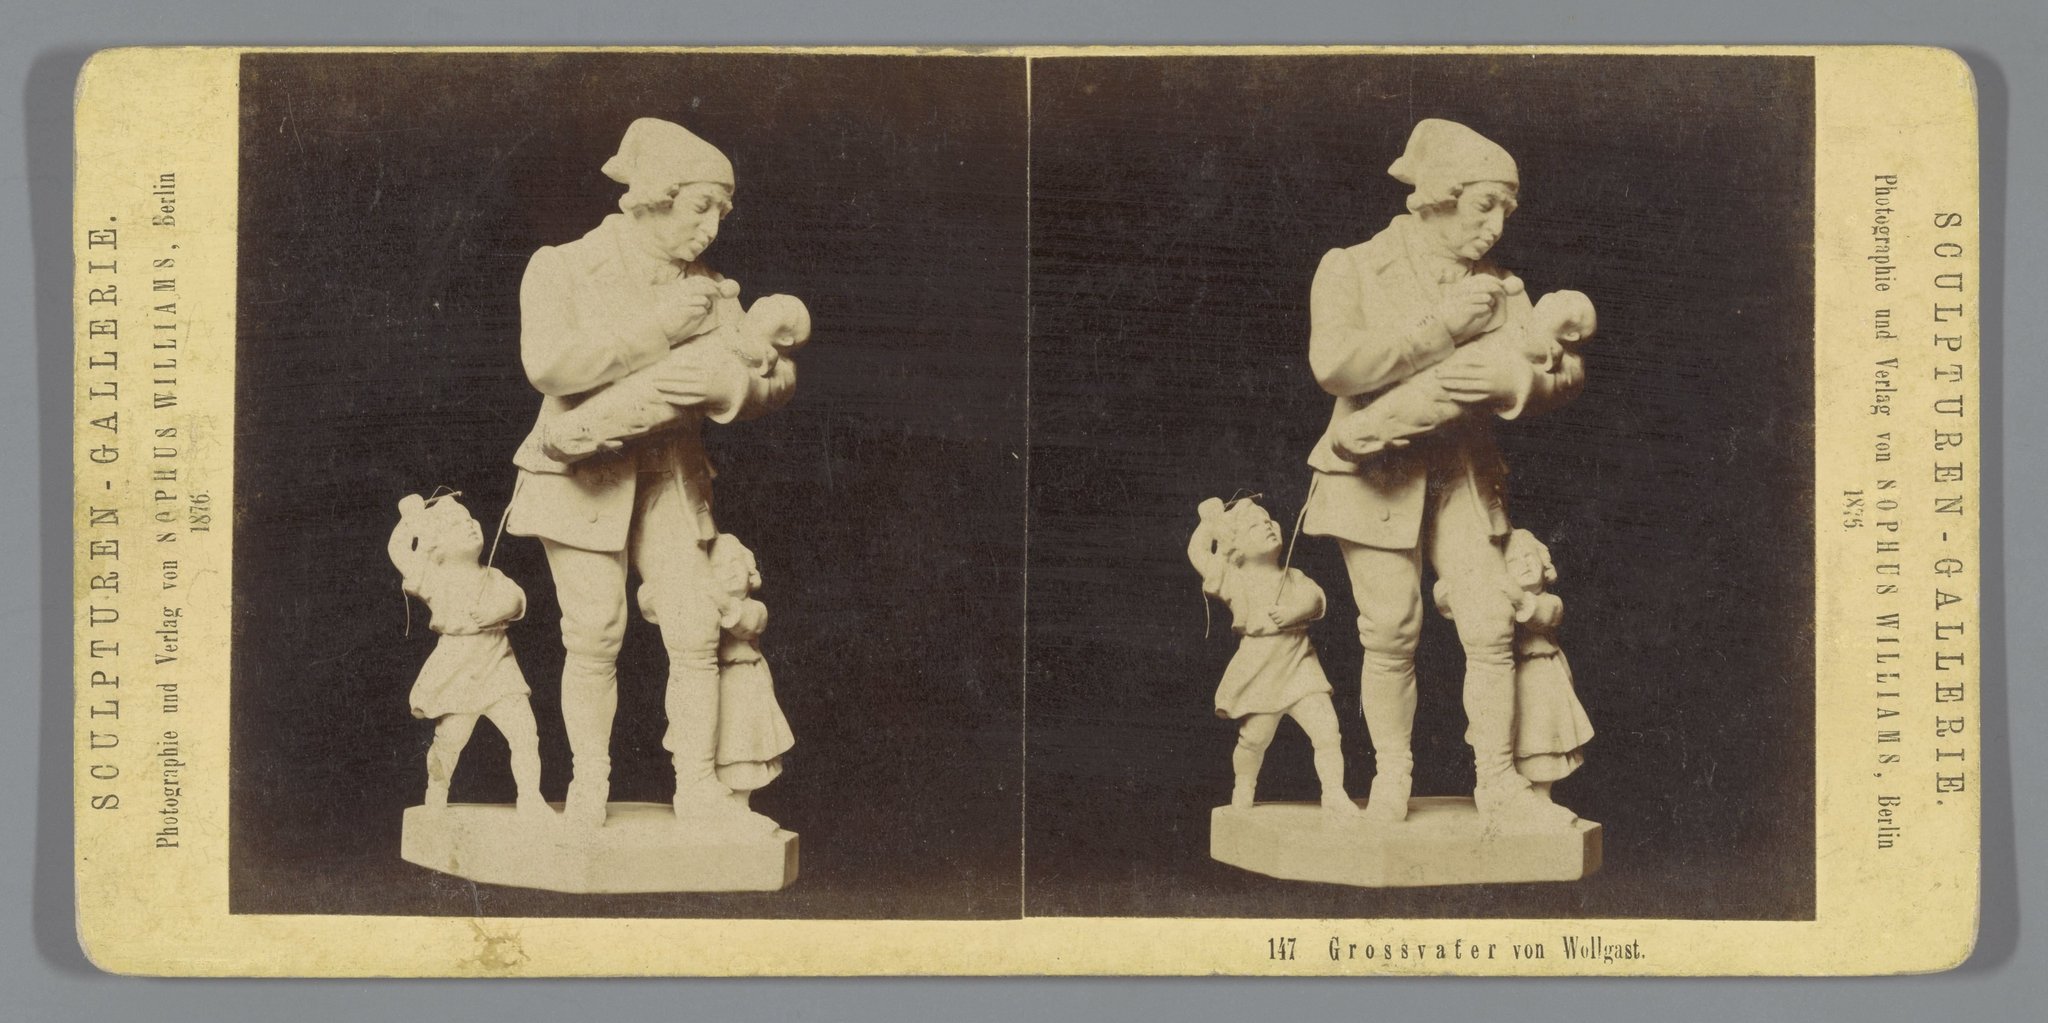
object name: stereograph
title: Sculpturen-Gallerie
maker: sophus williams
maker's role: publisher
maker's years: 1835-1900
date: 1875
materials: cardboard, photographic support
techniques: albumen print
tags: grandparent(s) with grandchild(ren) (family group), sculpture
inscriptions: number: ‘147’, : ‘Berlin’